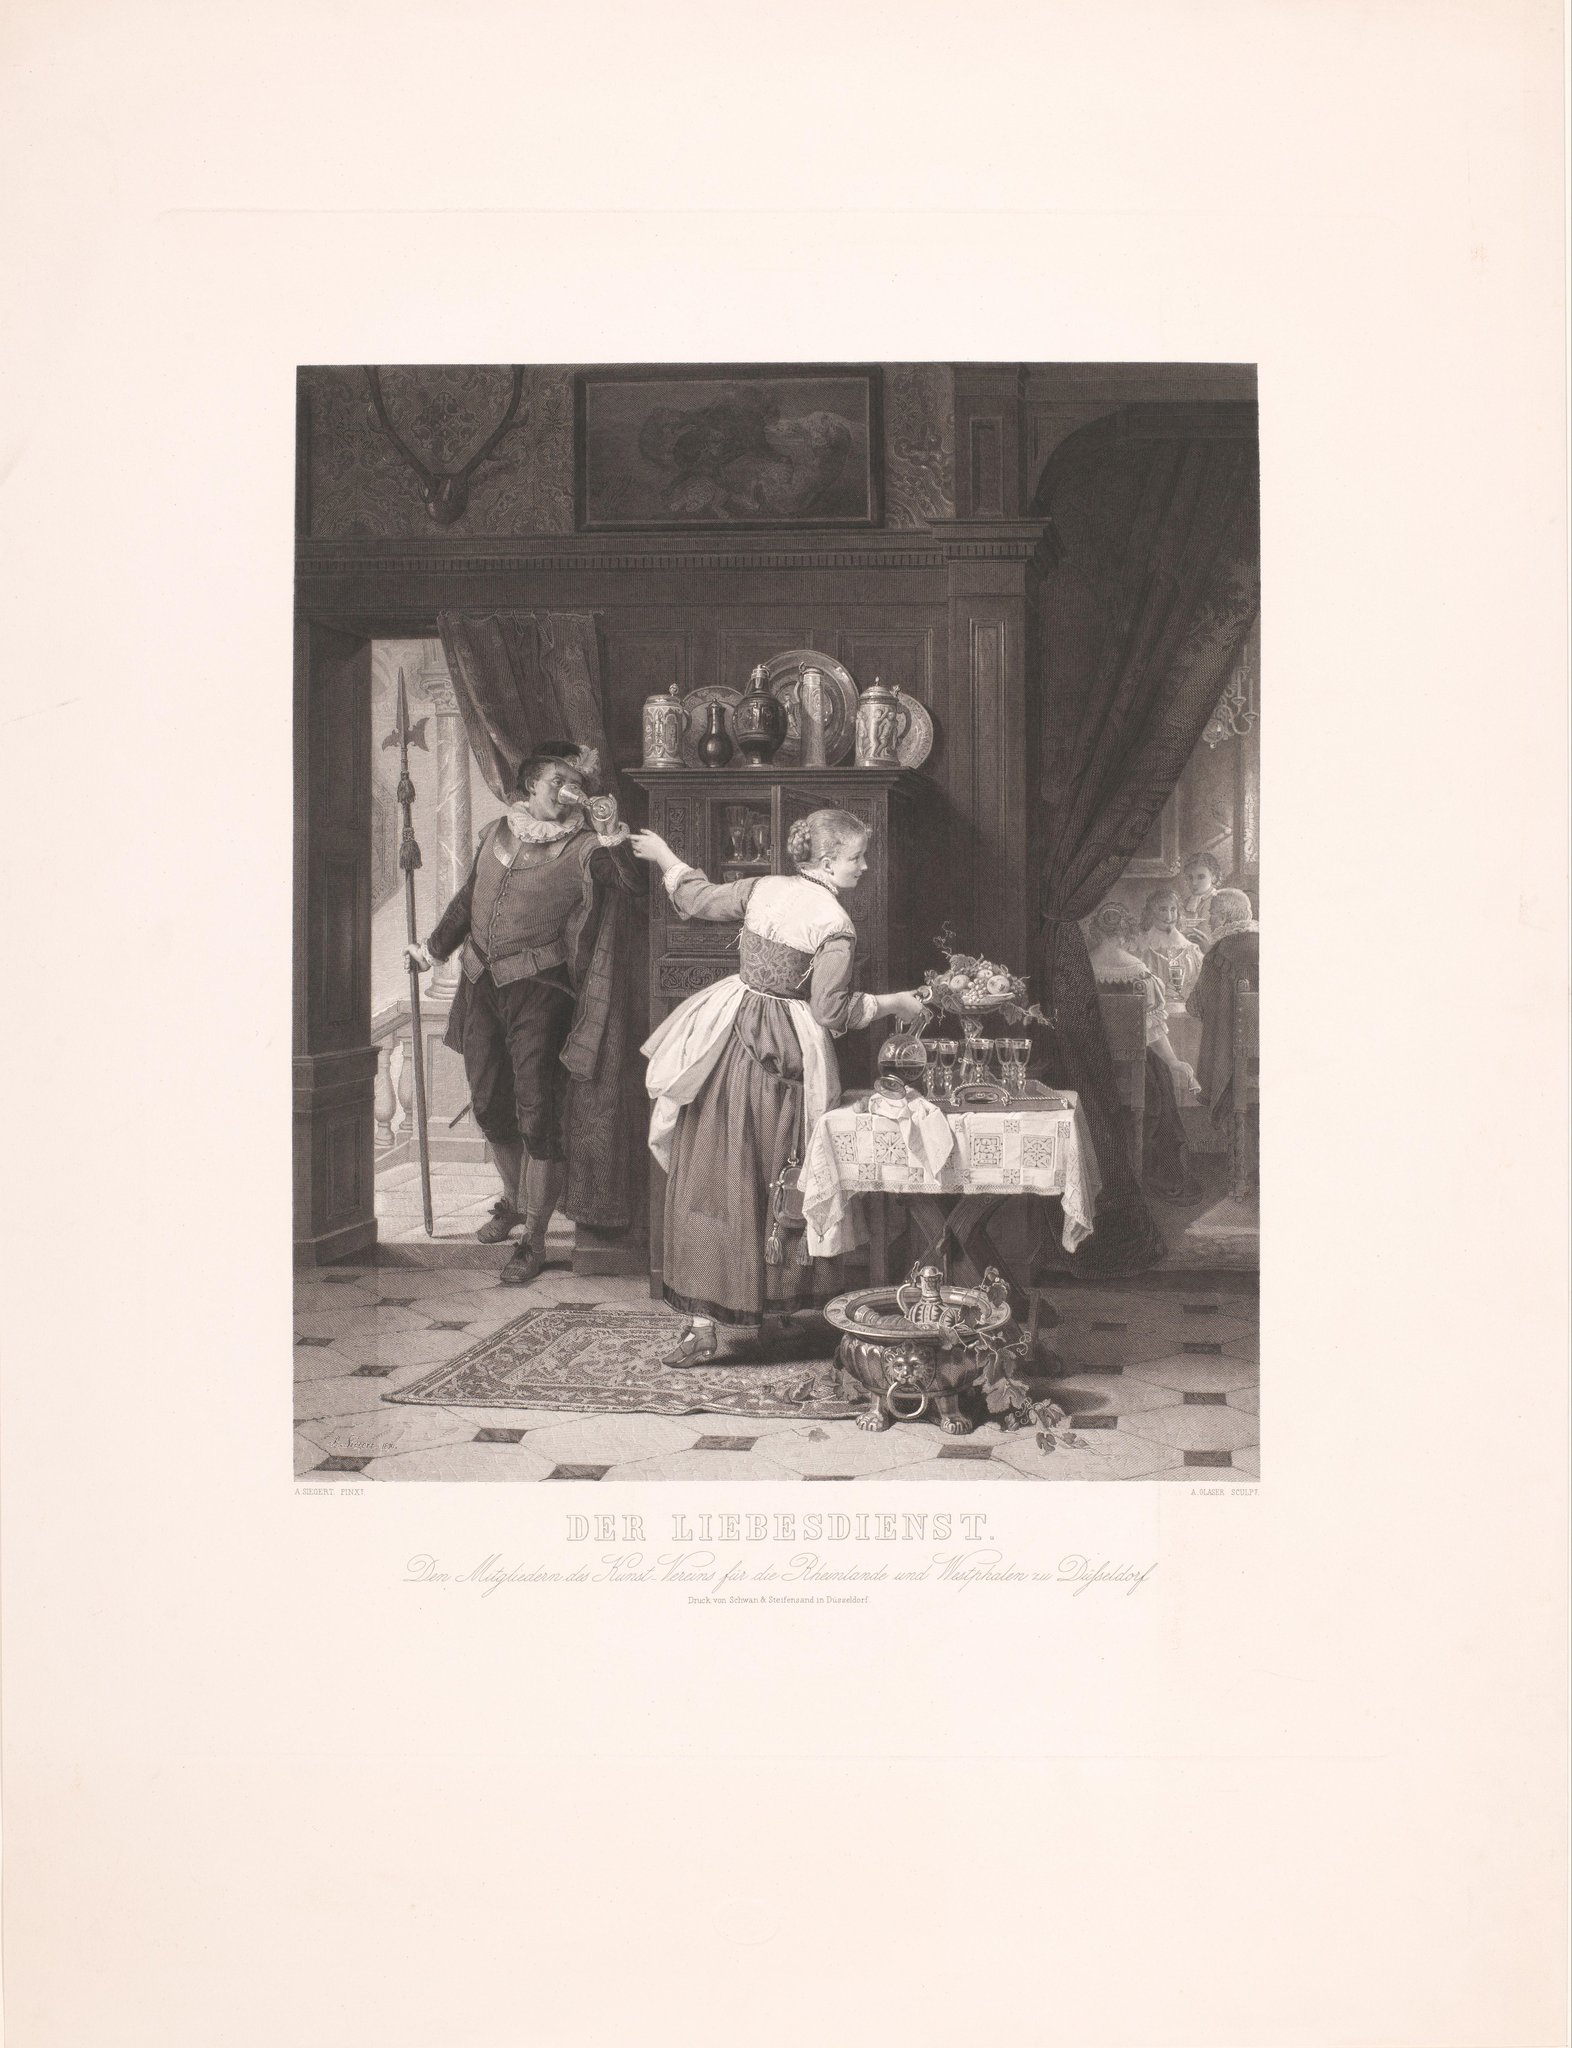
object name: print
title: Dienstmeid geeft de wachter een glas wijn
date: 1825-1900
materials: paper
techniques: engraving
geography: dusseldorf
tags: house-guard, doorkeeper, janitor, maid ~ house personnel, amorousness, desire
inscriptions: inscription: ‘Voor H[...]höffer wanneer zij trouwt’, collector's mark: Lugt 2228, address: ‘Kunstverein fur Rheinland Westphalen in Dusseldorf’